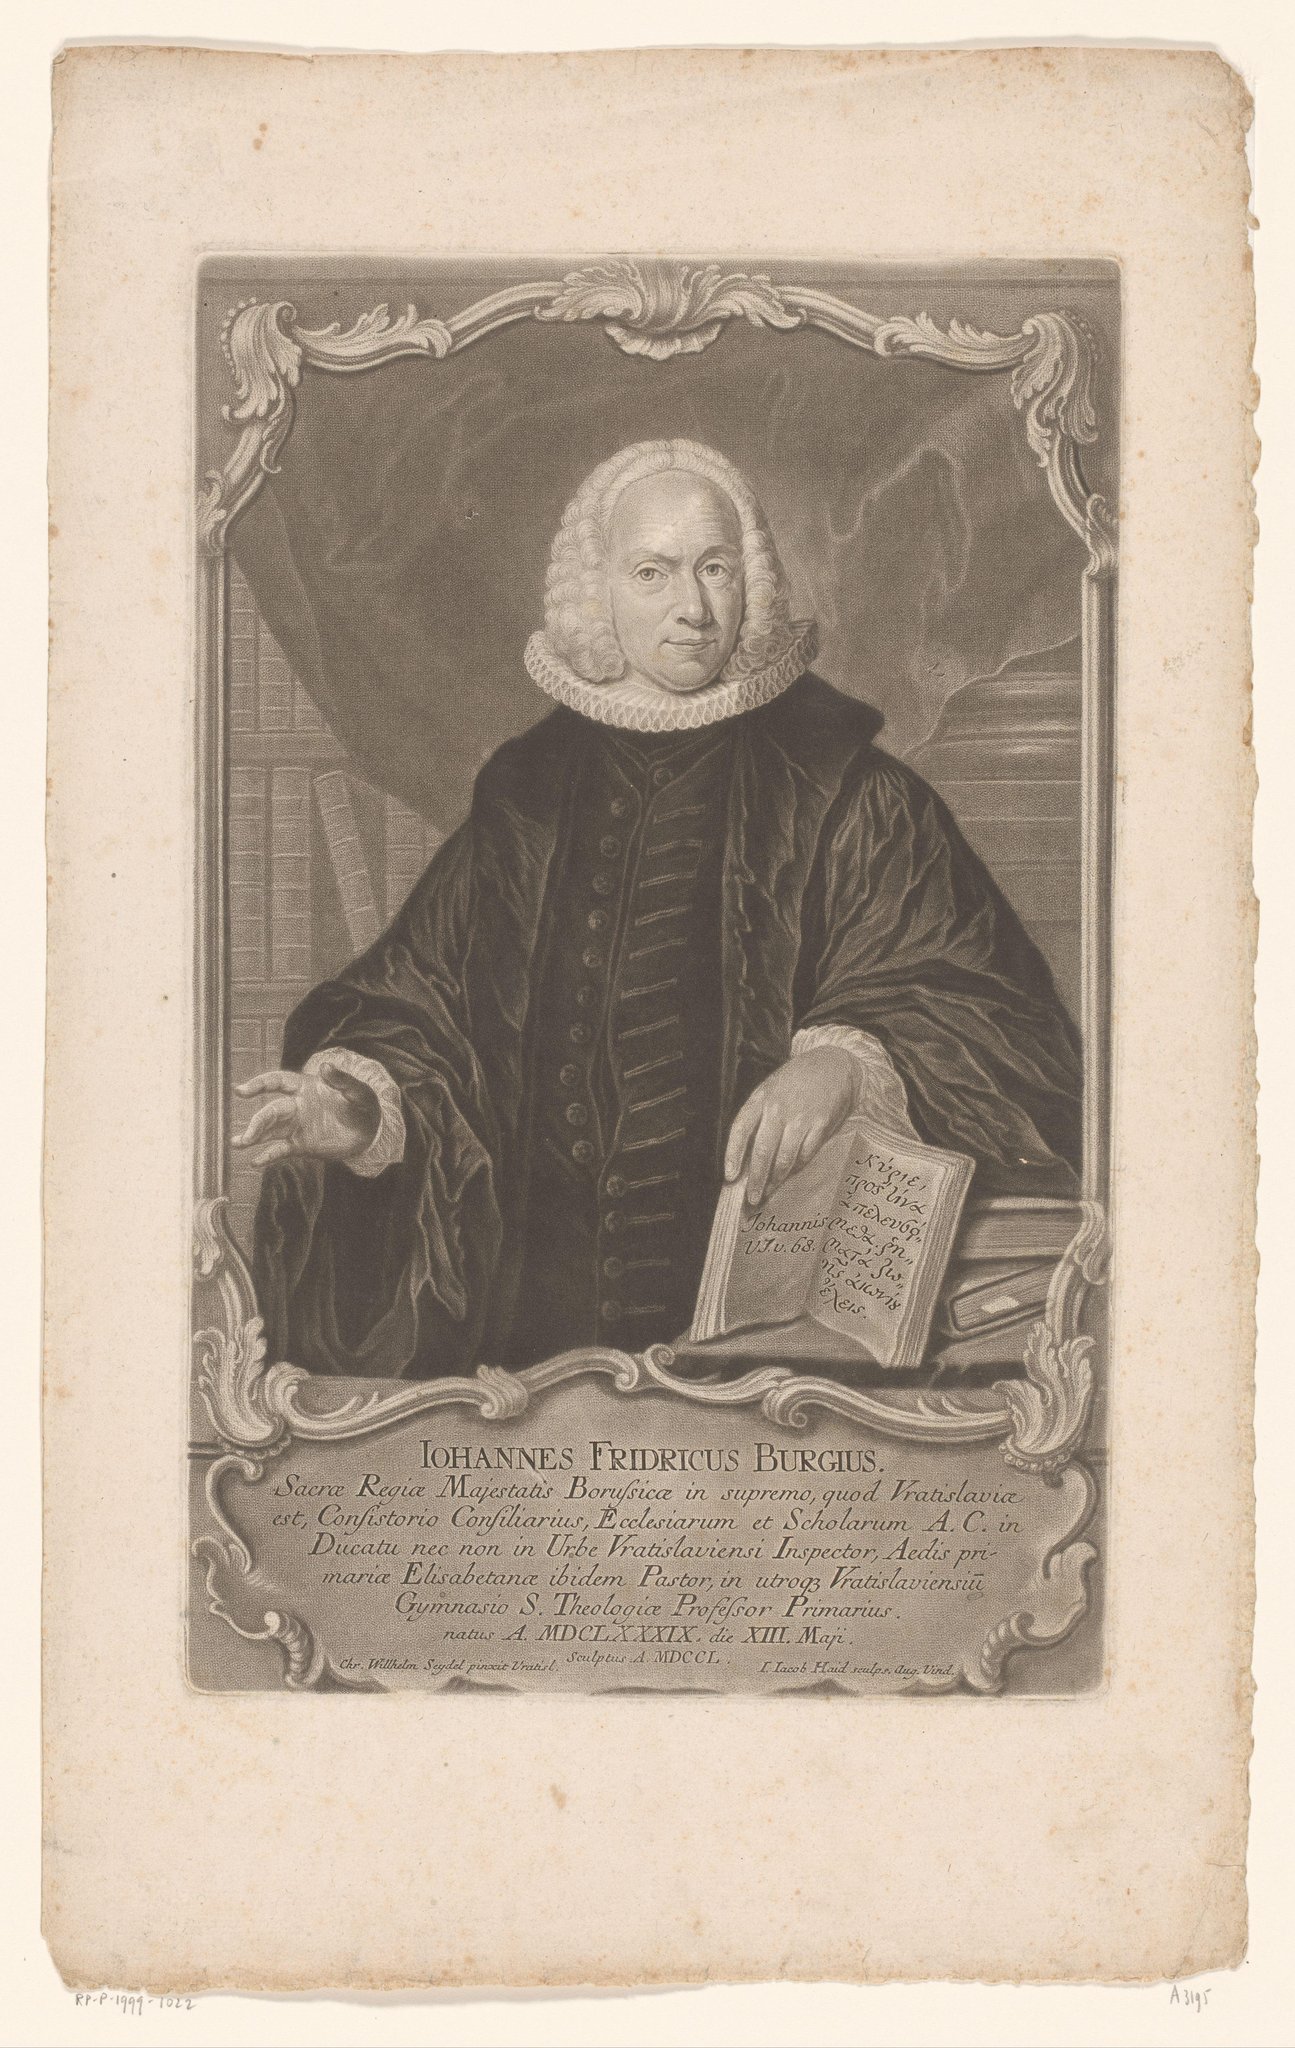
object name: print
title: Portret van Johann Friedrich Burg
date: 1750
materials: paper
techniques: mezzotint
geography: augsburg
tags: johann friedrich burg, bookshelves, rocaille ornament, theologian, historical persons, book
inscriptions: collector's mark: Lugt 2760, collector's mark: Lugt 2228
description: Prent gebruikt voor: Brucker, Jacob. Bildersal heutiges Tages lebender und durch Gelahrtheit berühmter Schrifftsteller. Augsburg: Johann Jacob Haid, 1750.